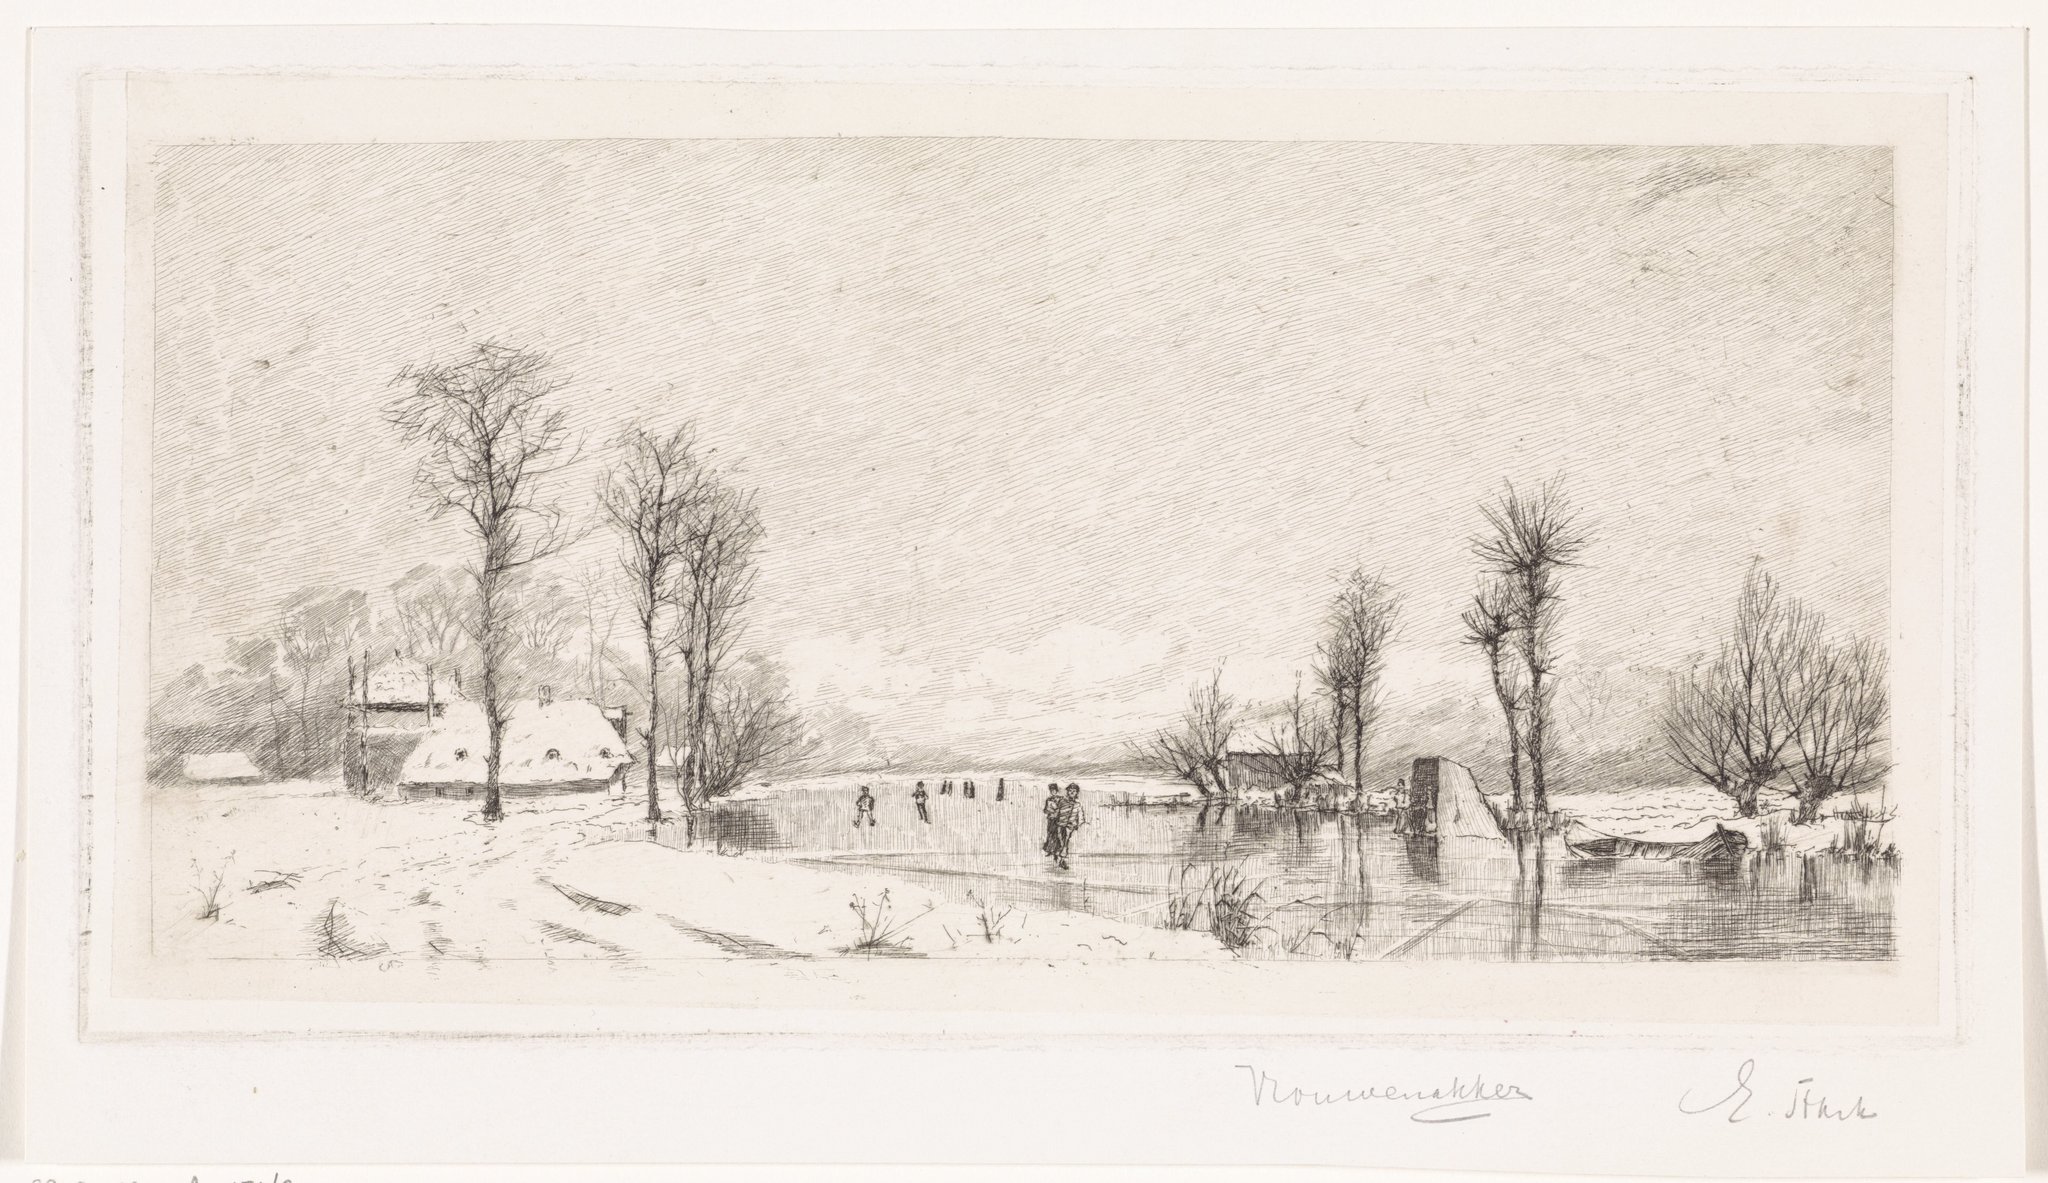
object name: print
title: Wintergezicht bij Vrouwenakker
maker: elias stark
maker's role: draughtsman, print maker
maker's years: 1849-1933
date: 1801-1888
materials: paper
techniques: etching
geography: nieuwer-amstel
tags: winter landscape; landscape symbolizing winter (the four seasons of the year), skates (winter sports)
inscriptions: collector's mark: Lugt 2228, inscription: ‘Vrouwenakker E. Stark’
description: Wintergezicht bij Vrouwenakker met schaatsers op het bevroren riviertje de Drecht.